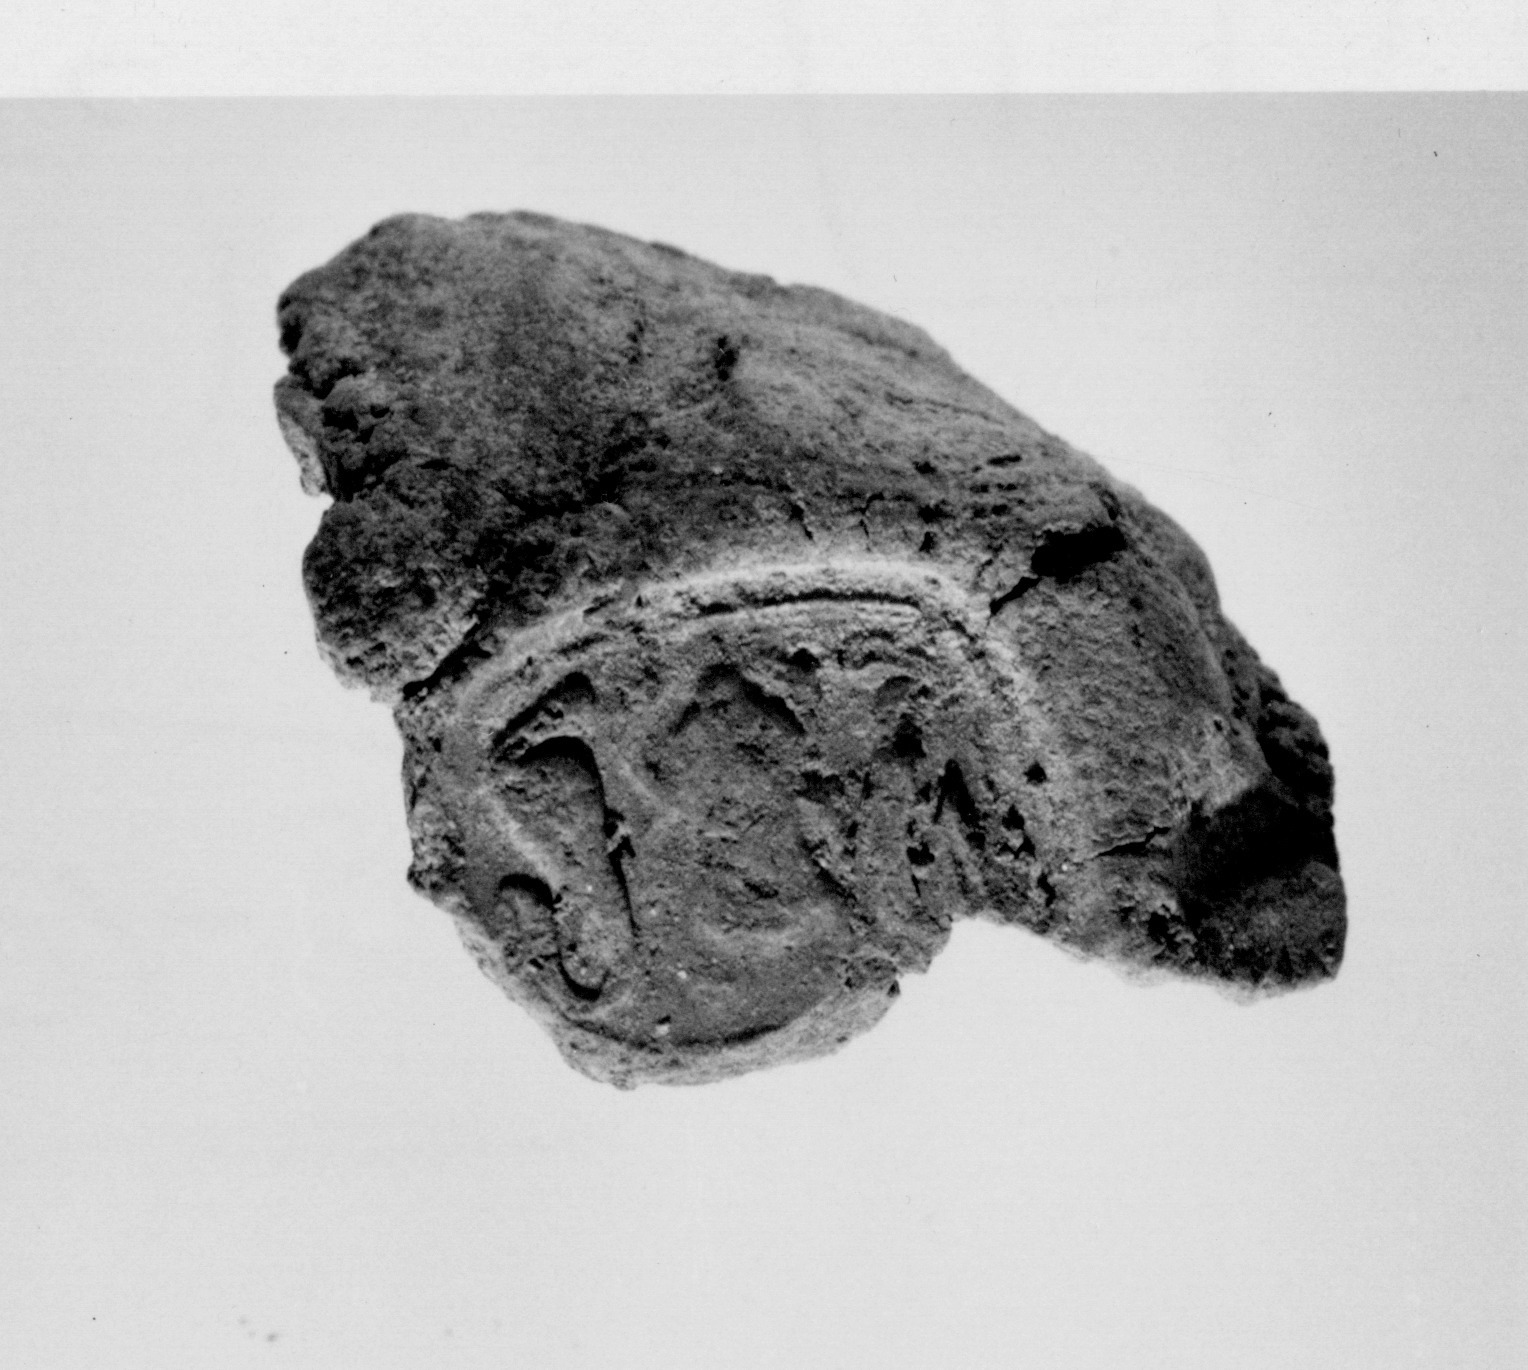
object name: sealing, cobra, scarab, uraeus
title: Document Sealing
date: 1390-1352 BCE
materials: mud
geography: egypt